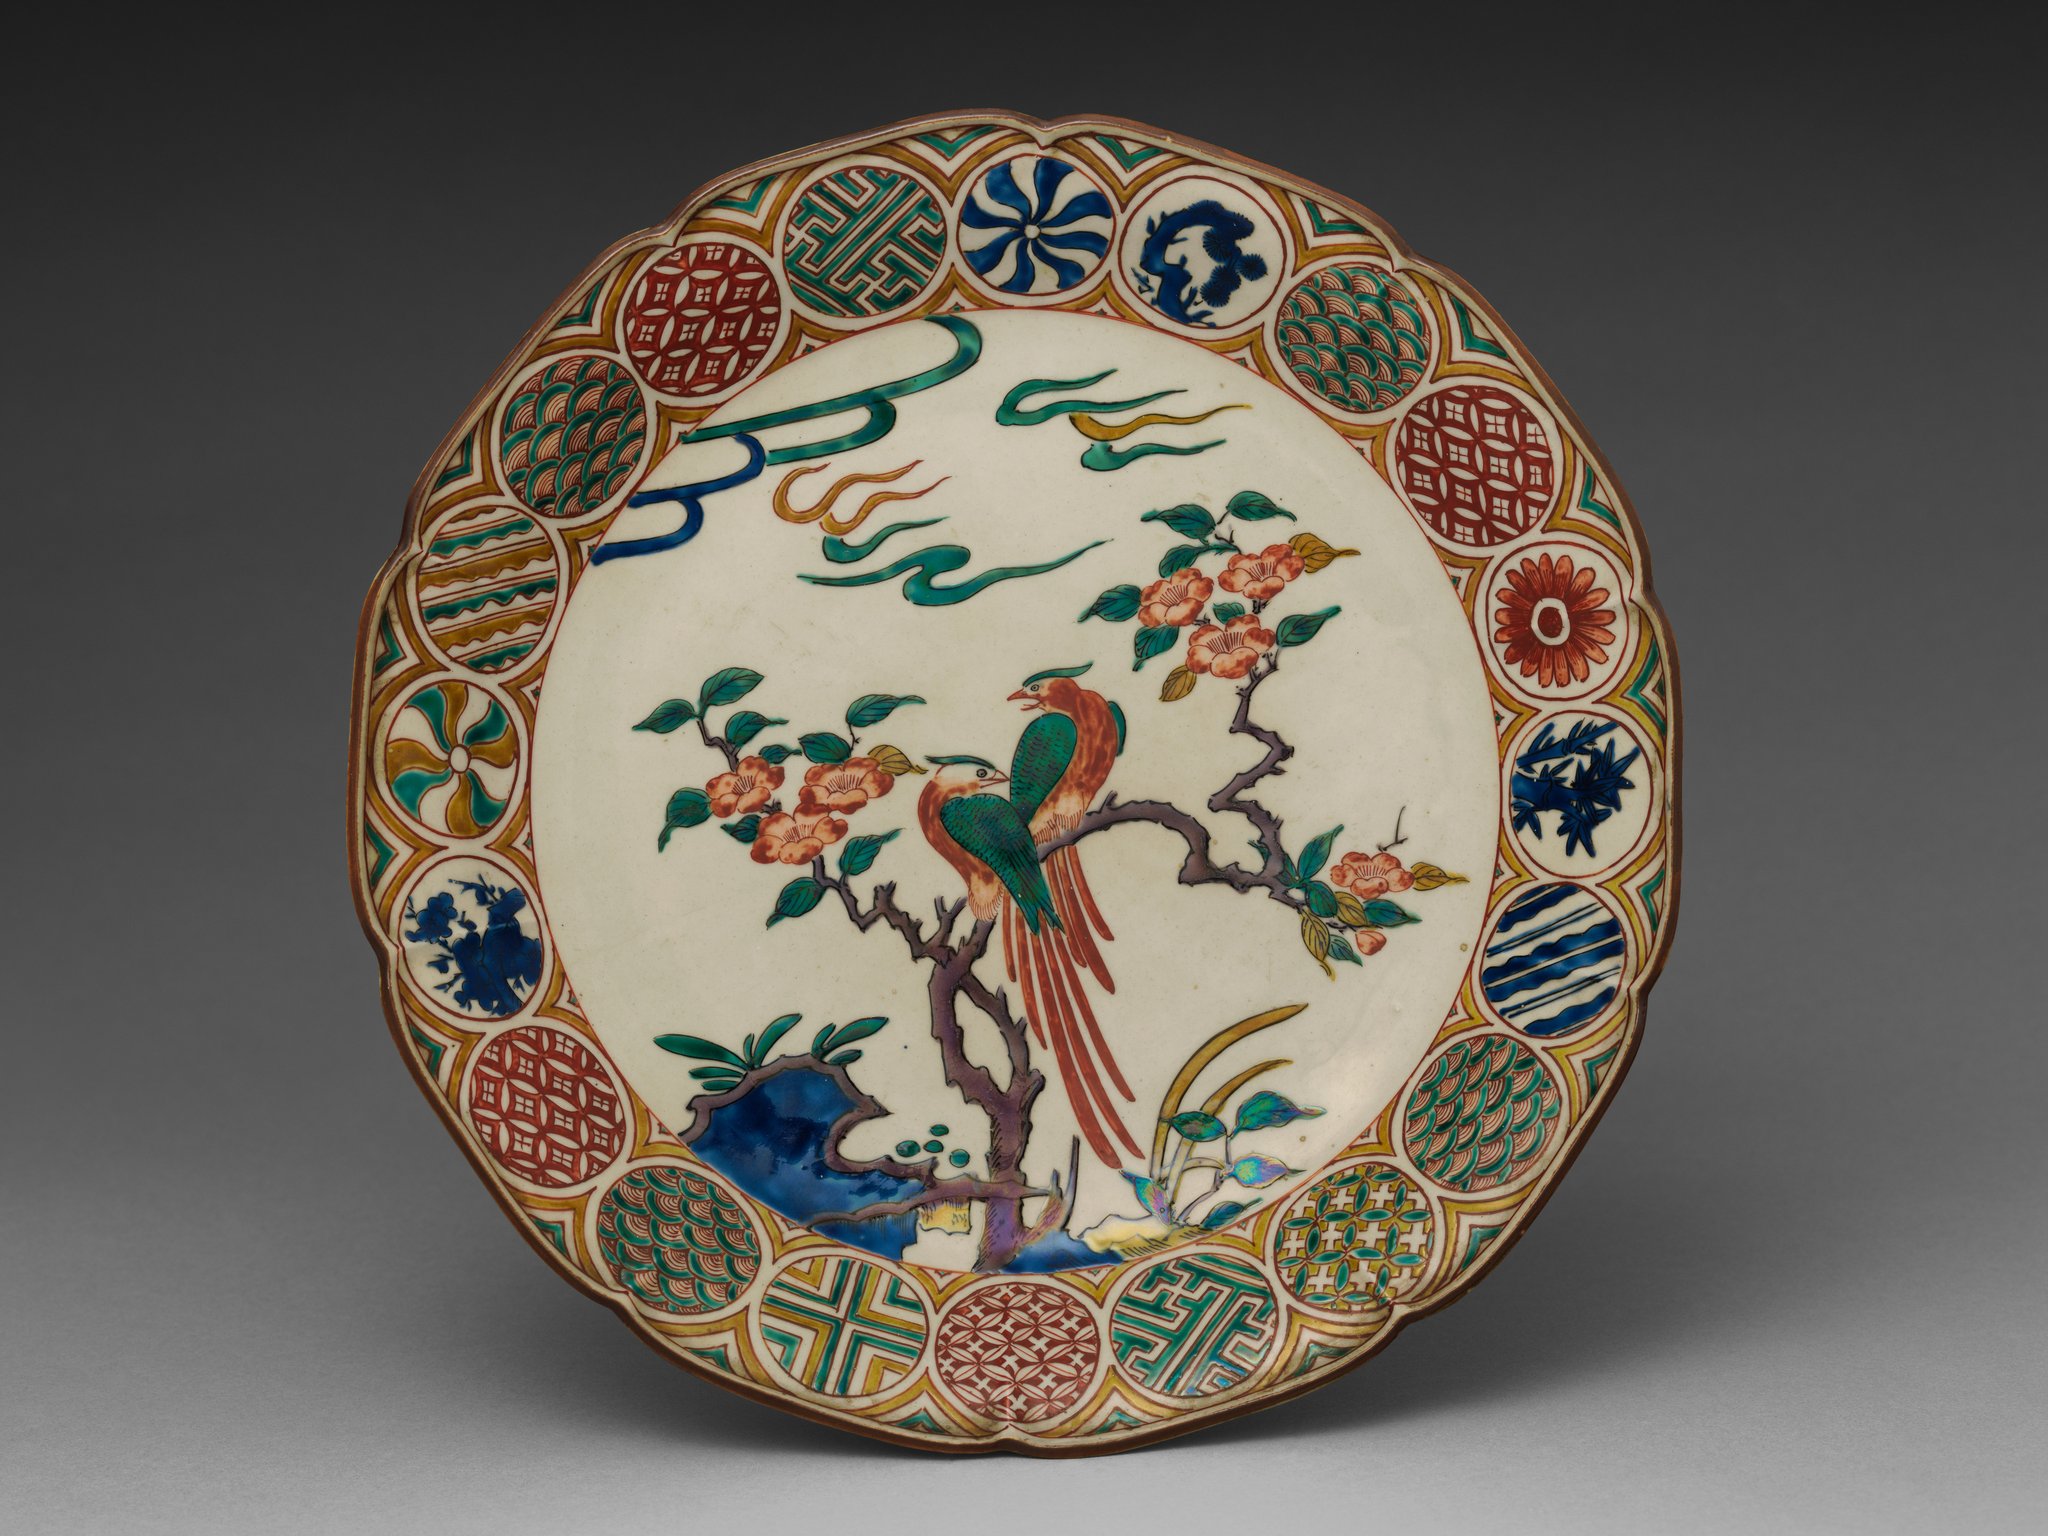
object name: plate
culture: japanese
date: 1801-1900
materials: enamel, pottery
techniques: polychrome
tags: birds